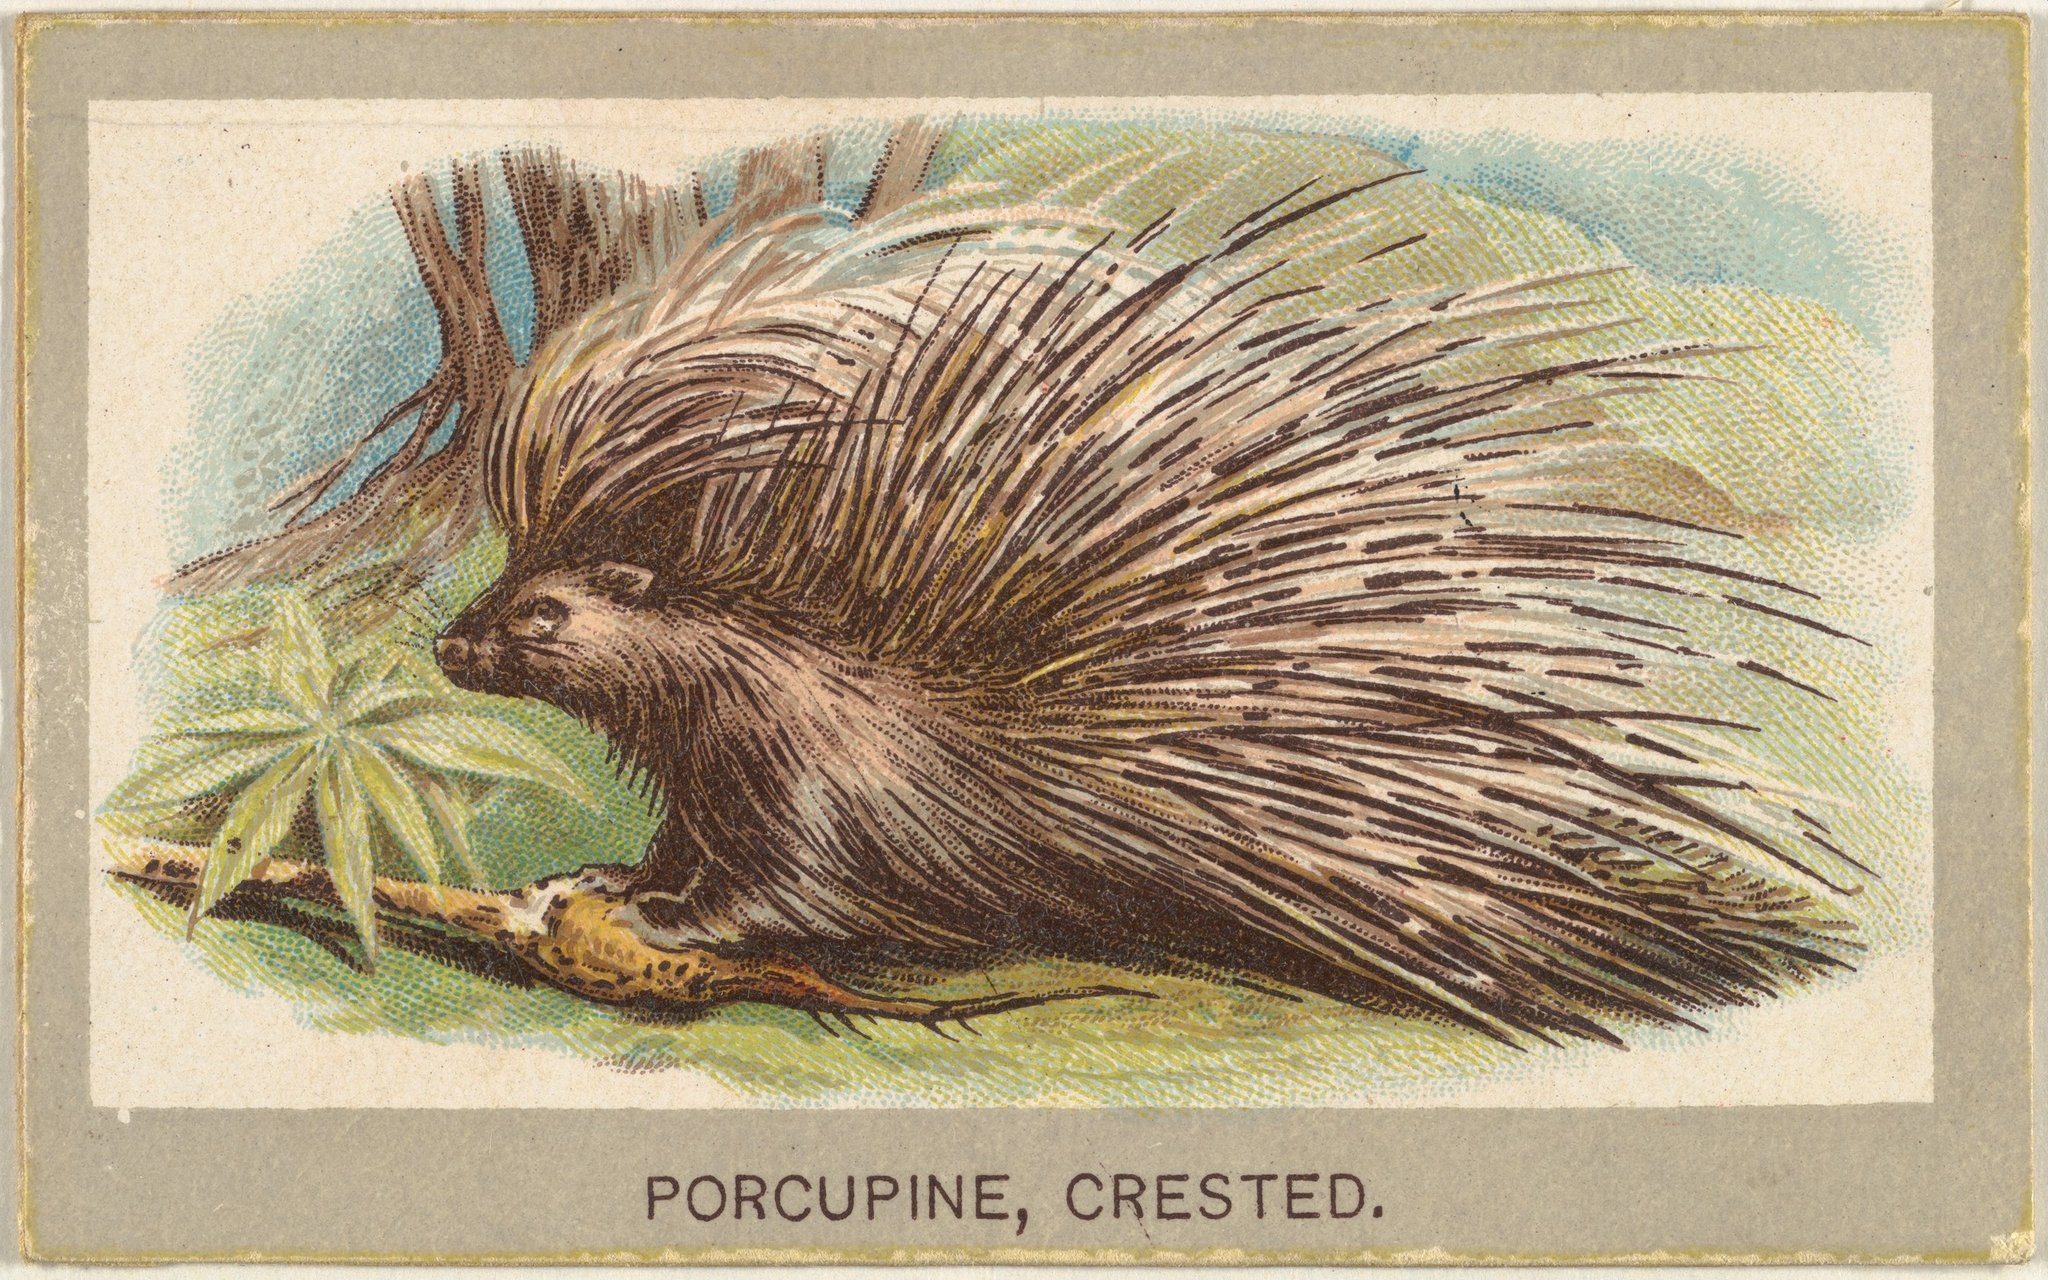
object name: print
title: Crested Porcupine, from the Animals of the World series (T180), issued by Abdul Cigarettes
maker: abdul cigarettes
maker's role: publisher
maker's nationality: american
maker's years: 1881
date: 1881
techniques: color lithograph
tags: animals